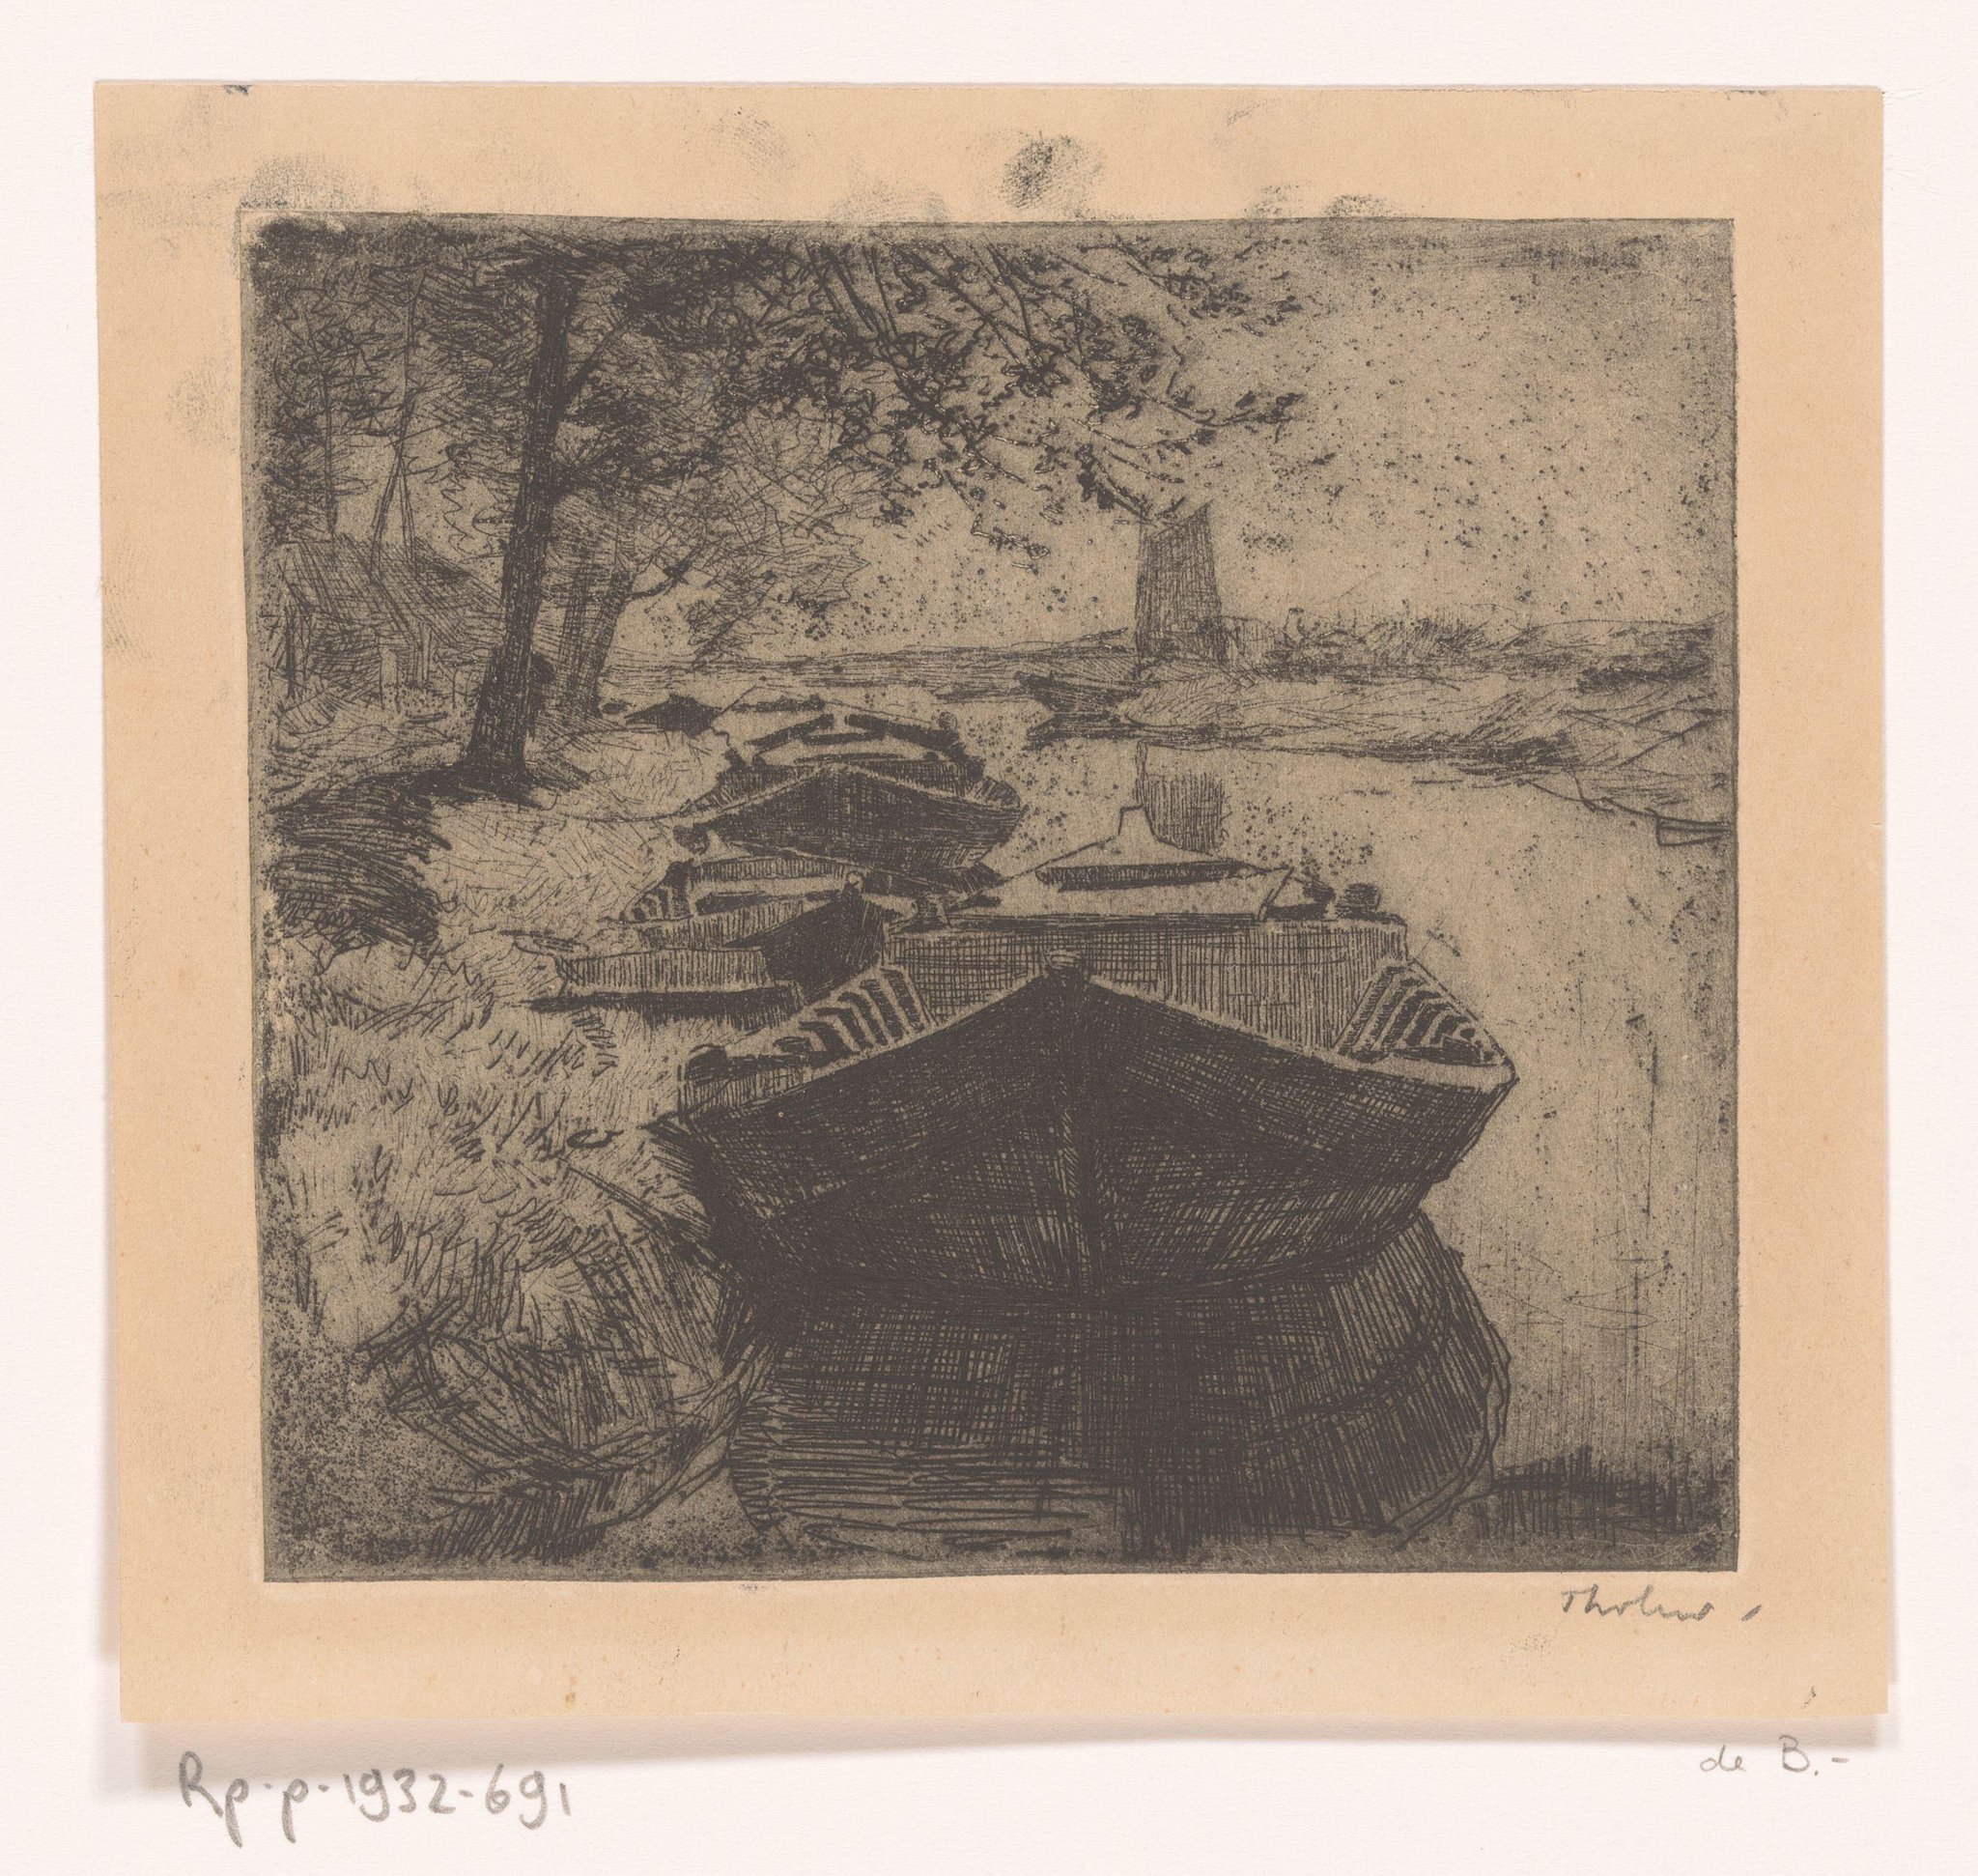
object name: print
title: Vaart met schuiten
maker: willem bastiaan tholen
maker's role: draughtsman, painter, print maker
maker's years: 1860-1931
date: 1870-1931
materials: paper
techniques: etching, intaglio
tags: sailing-ship, sailing-boat, canal, rowing-boat, canoe, etc.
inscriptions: collector's mark: Lugt 2228